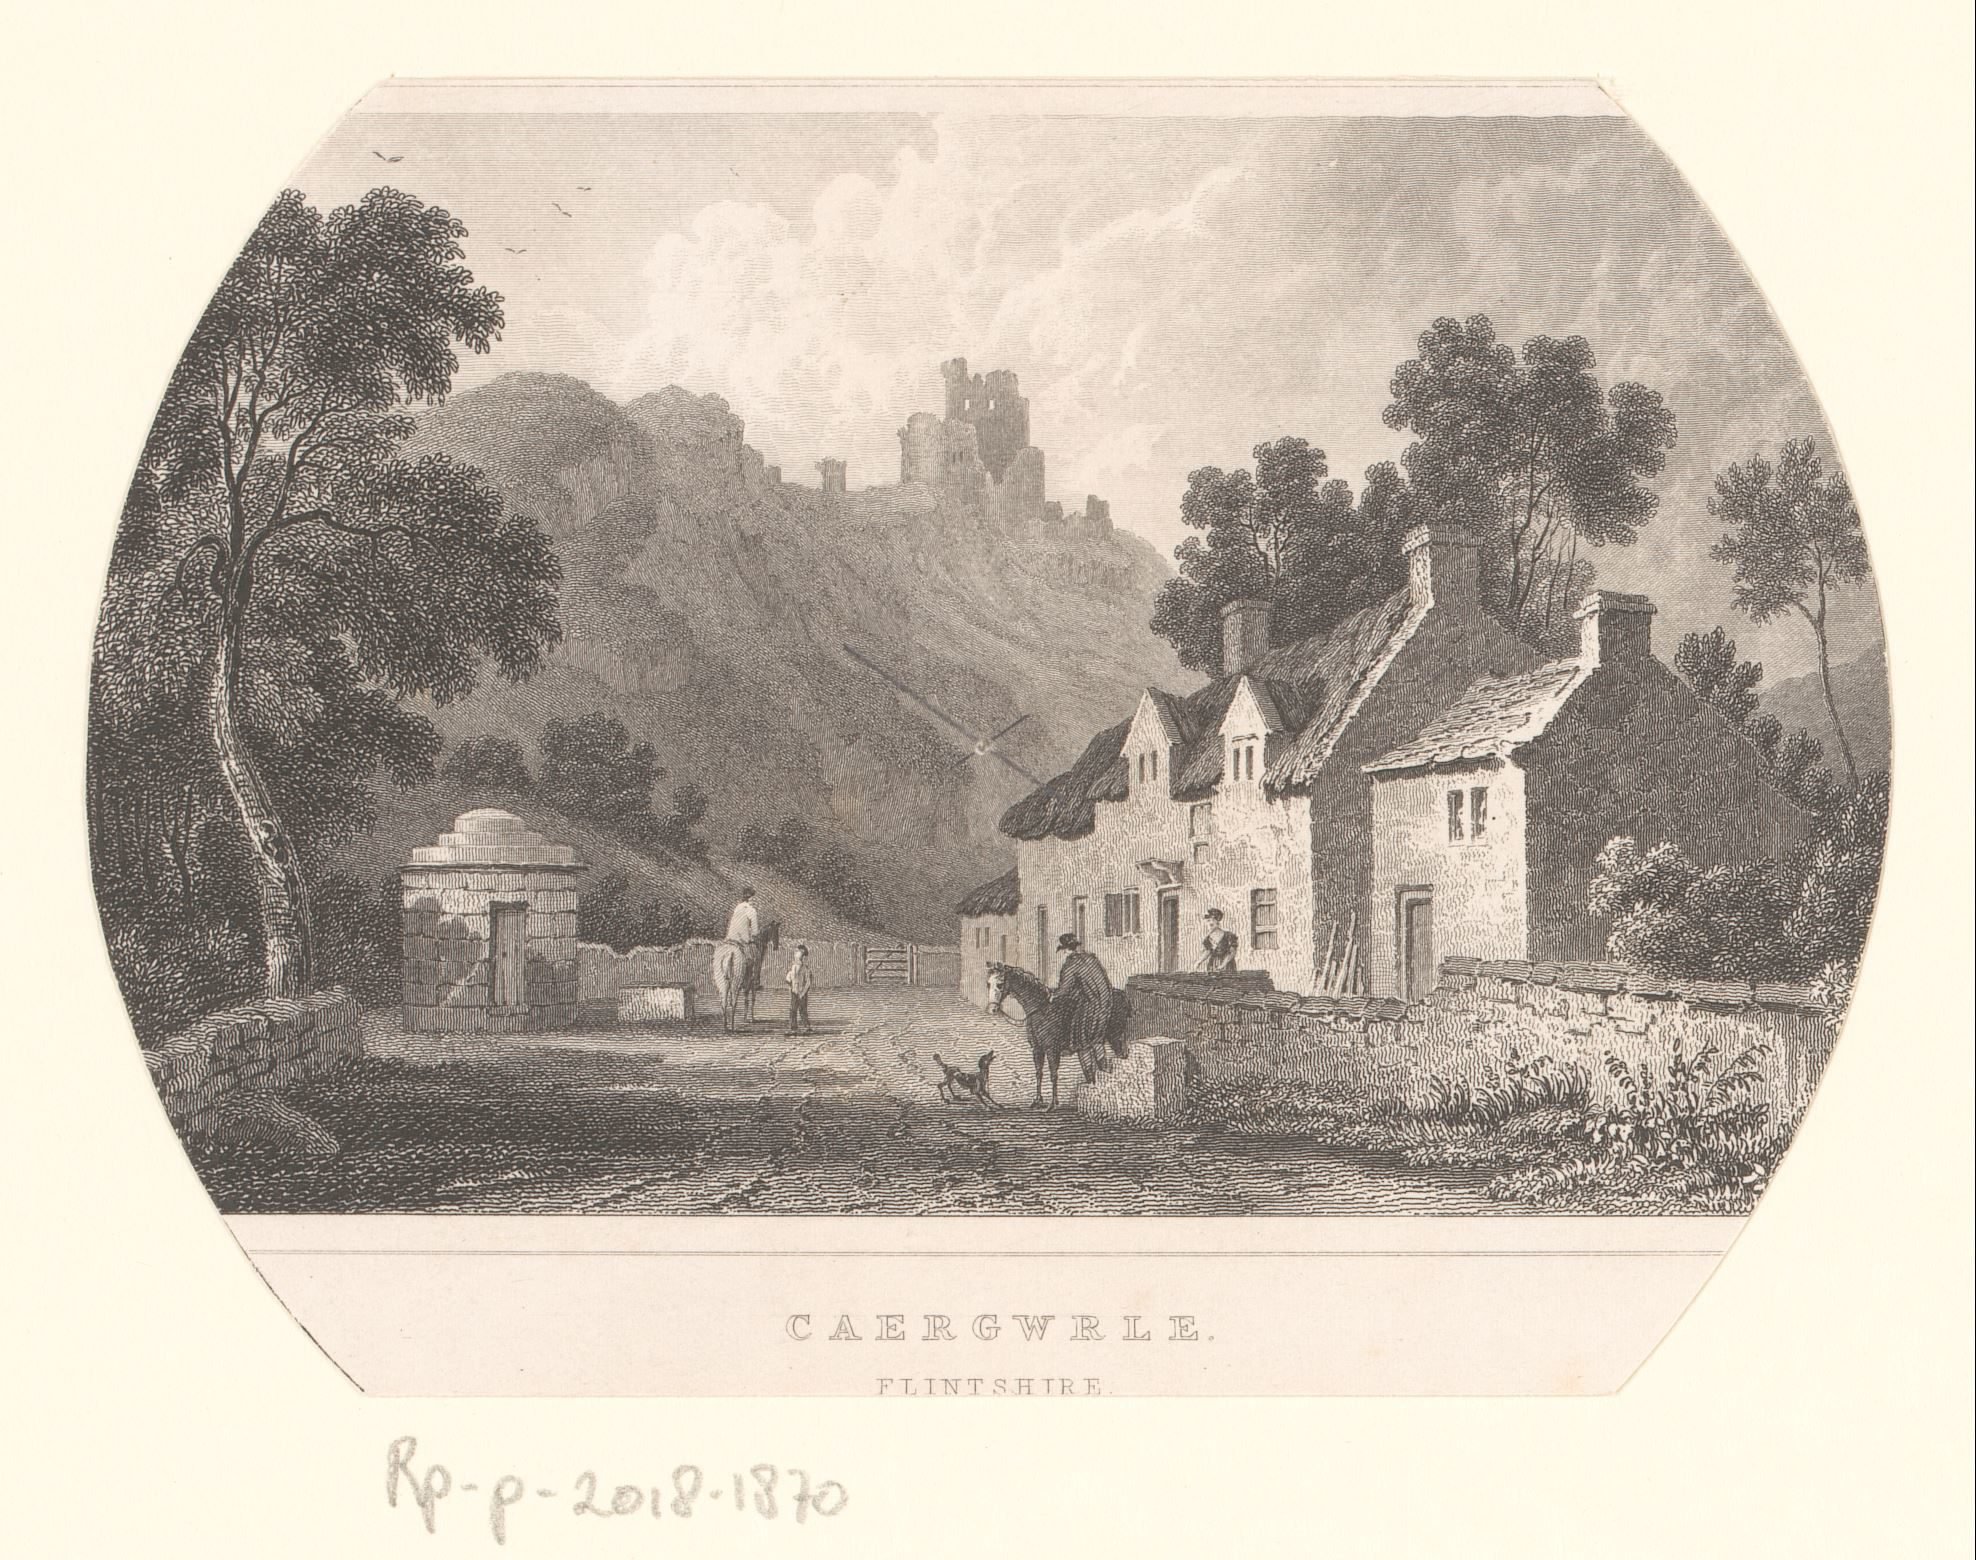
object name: print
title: Caergwrle Flintshire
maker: Anonymous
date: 1800-1899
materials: paper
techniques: etching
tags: castle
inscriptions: collector's mark: Lugt 2228